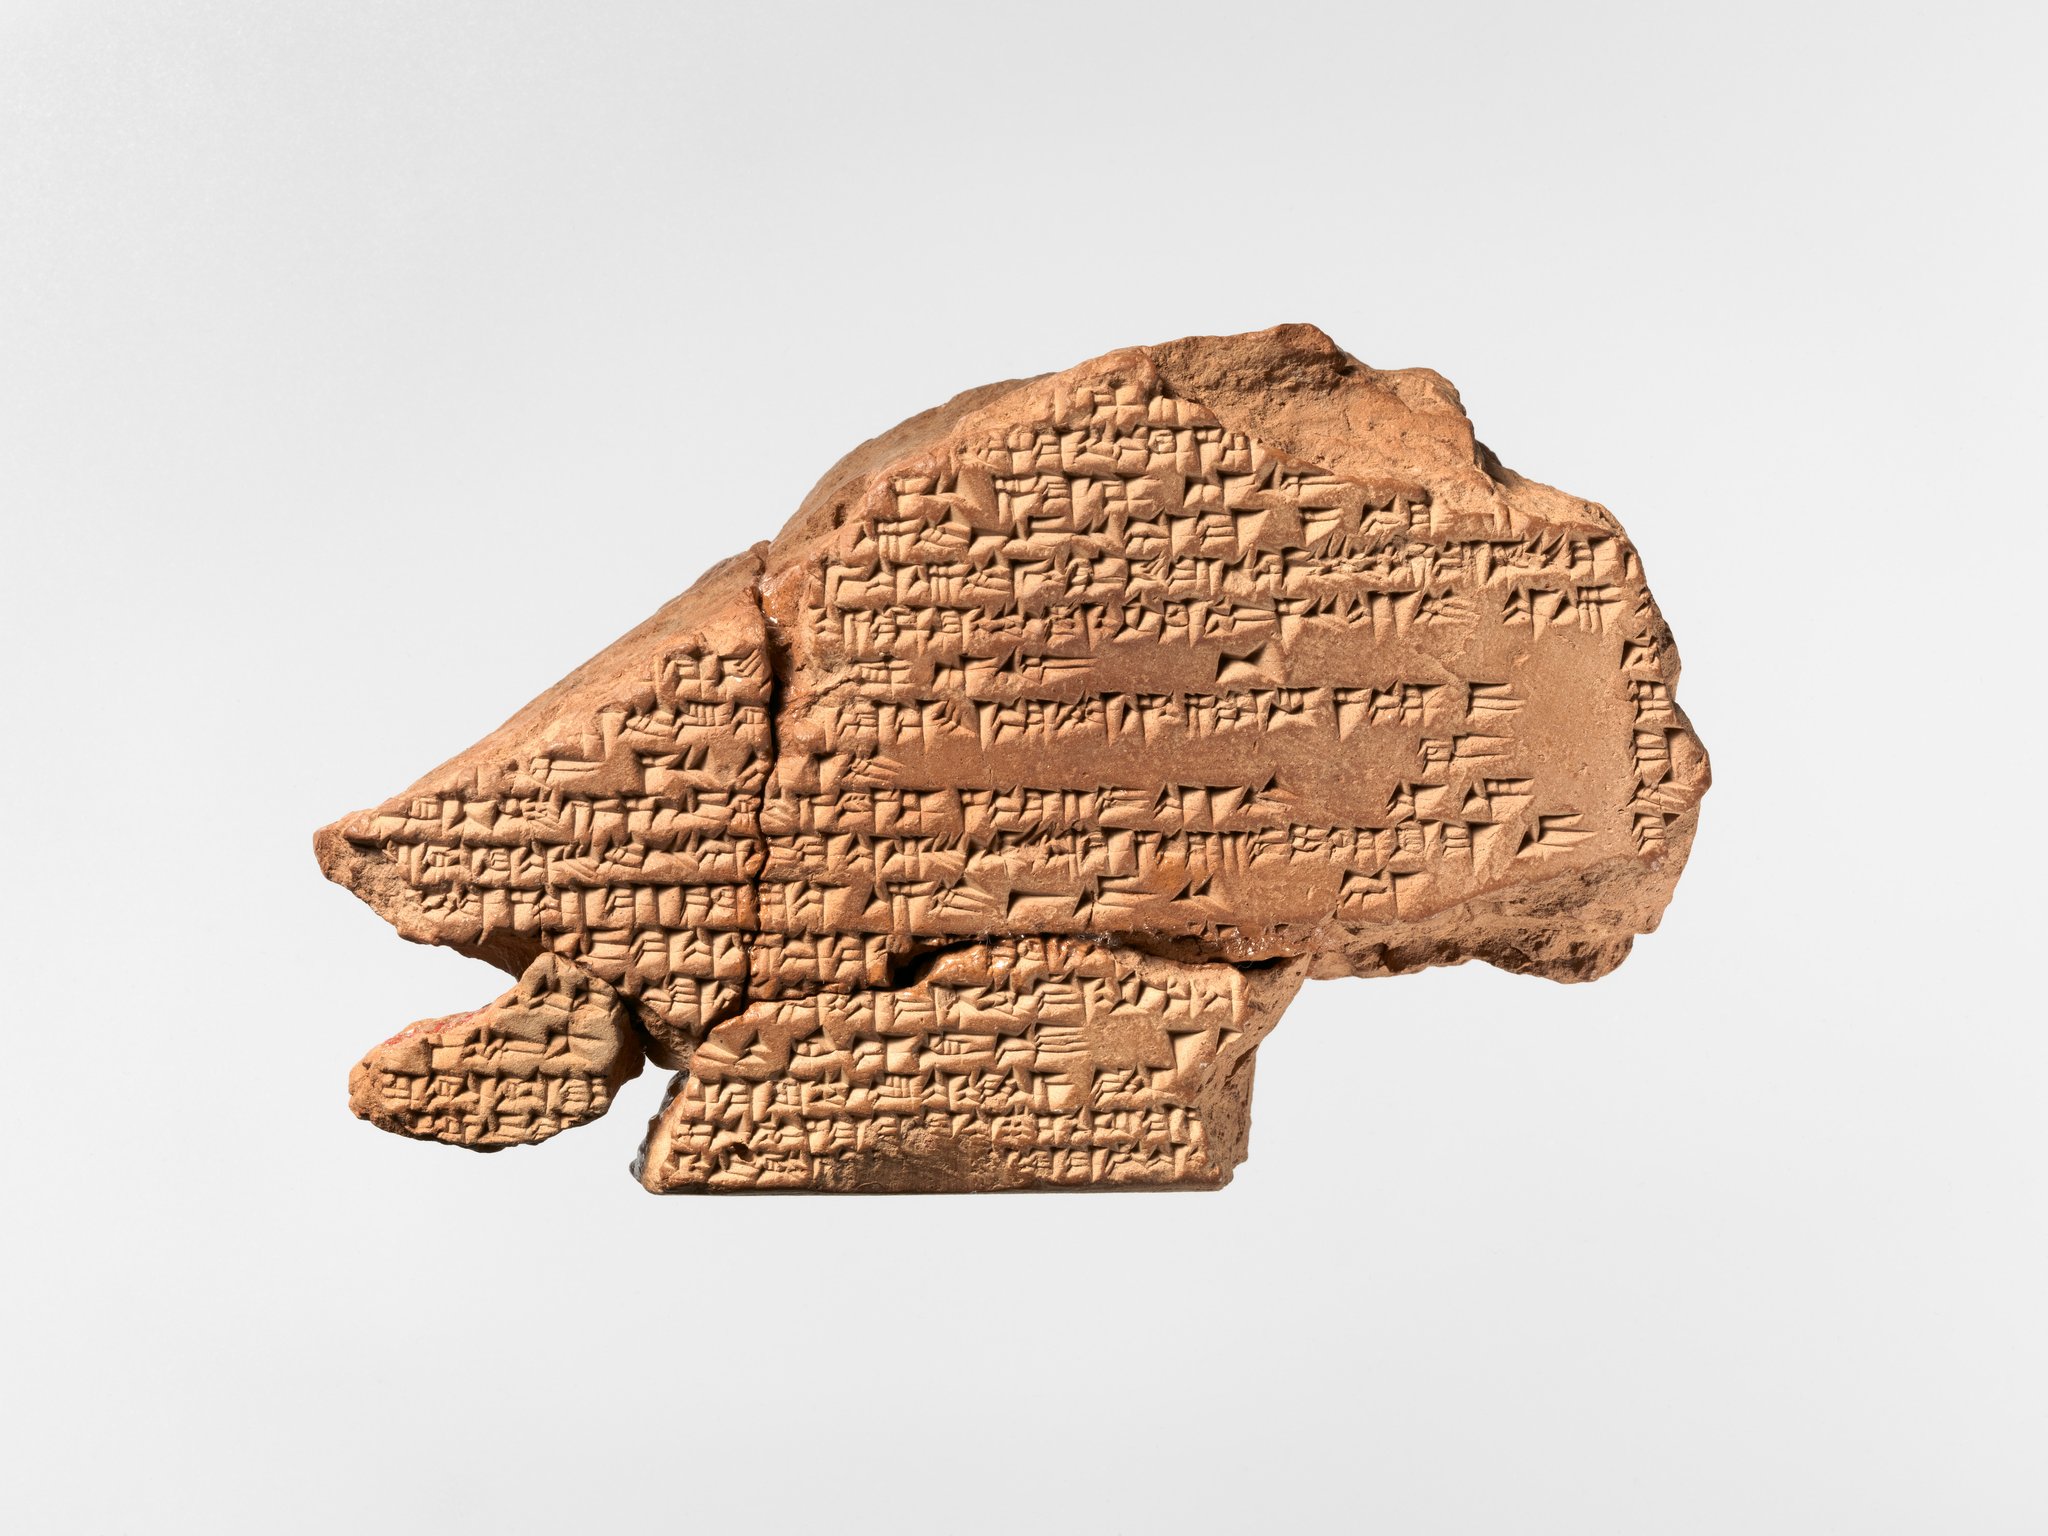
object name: cuneiform tablet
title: Cuneiform tablet: commentary on Enuma Anu Enlil, tablet 5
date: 333-1 BCE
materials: clay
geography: mesopotamia